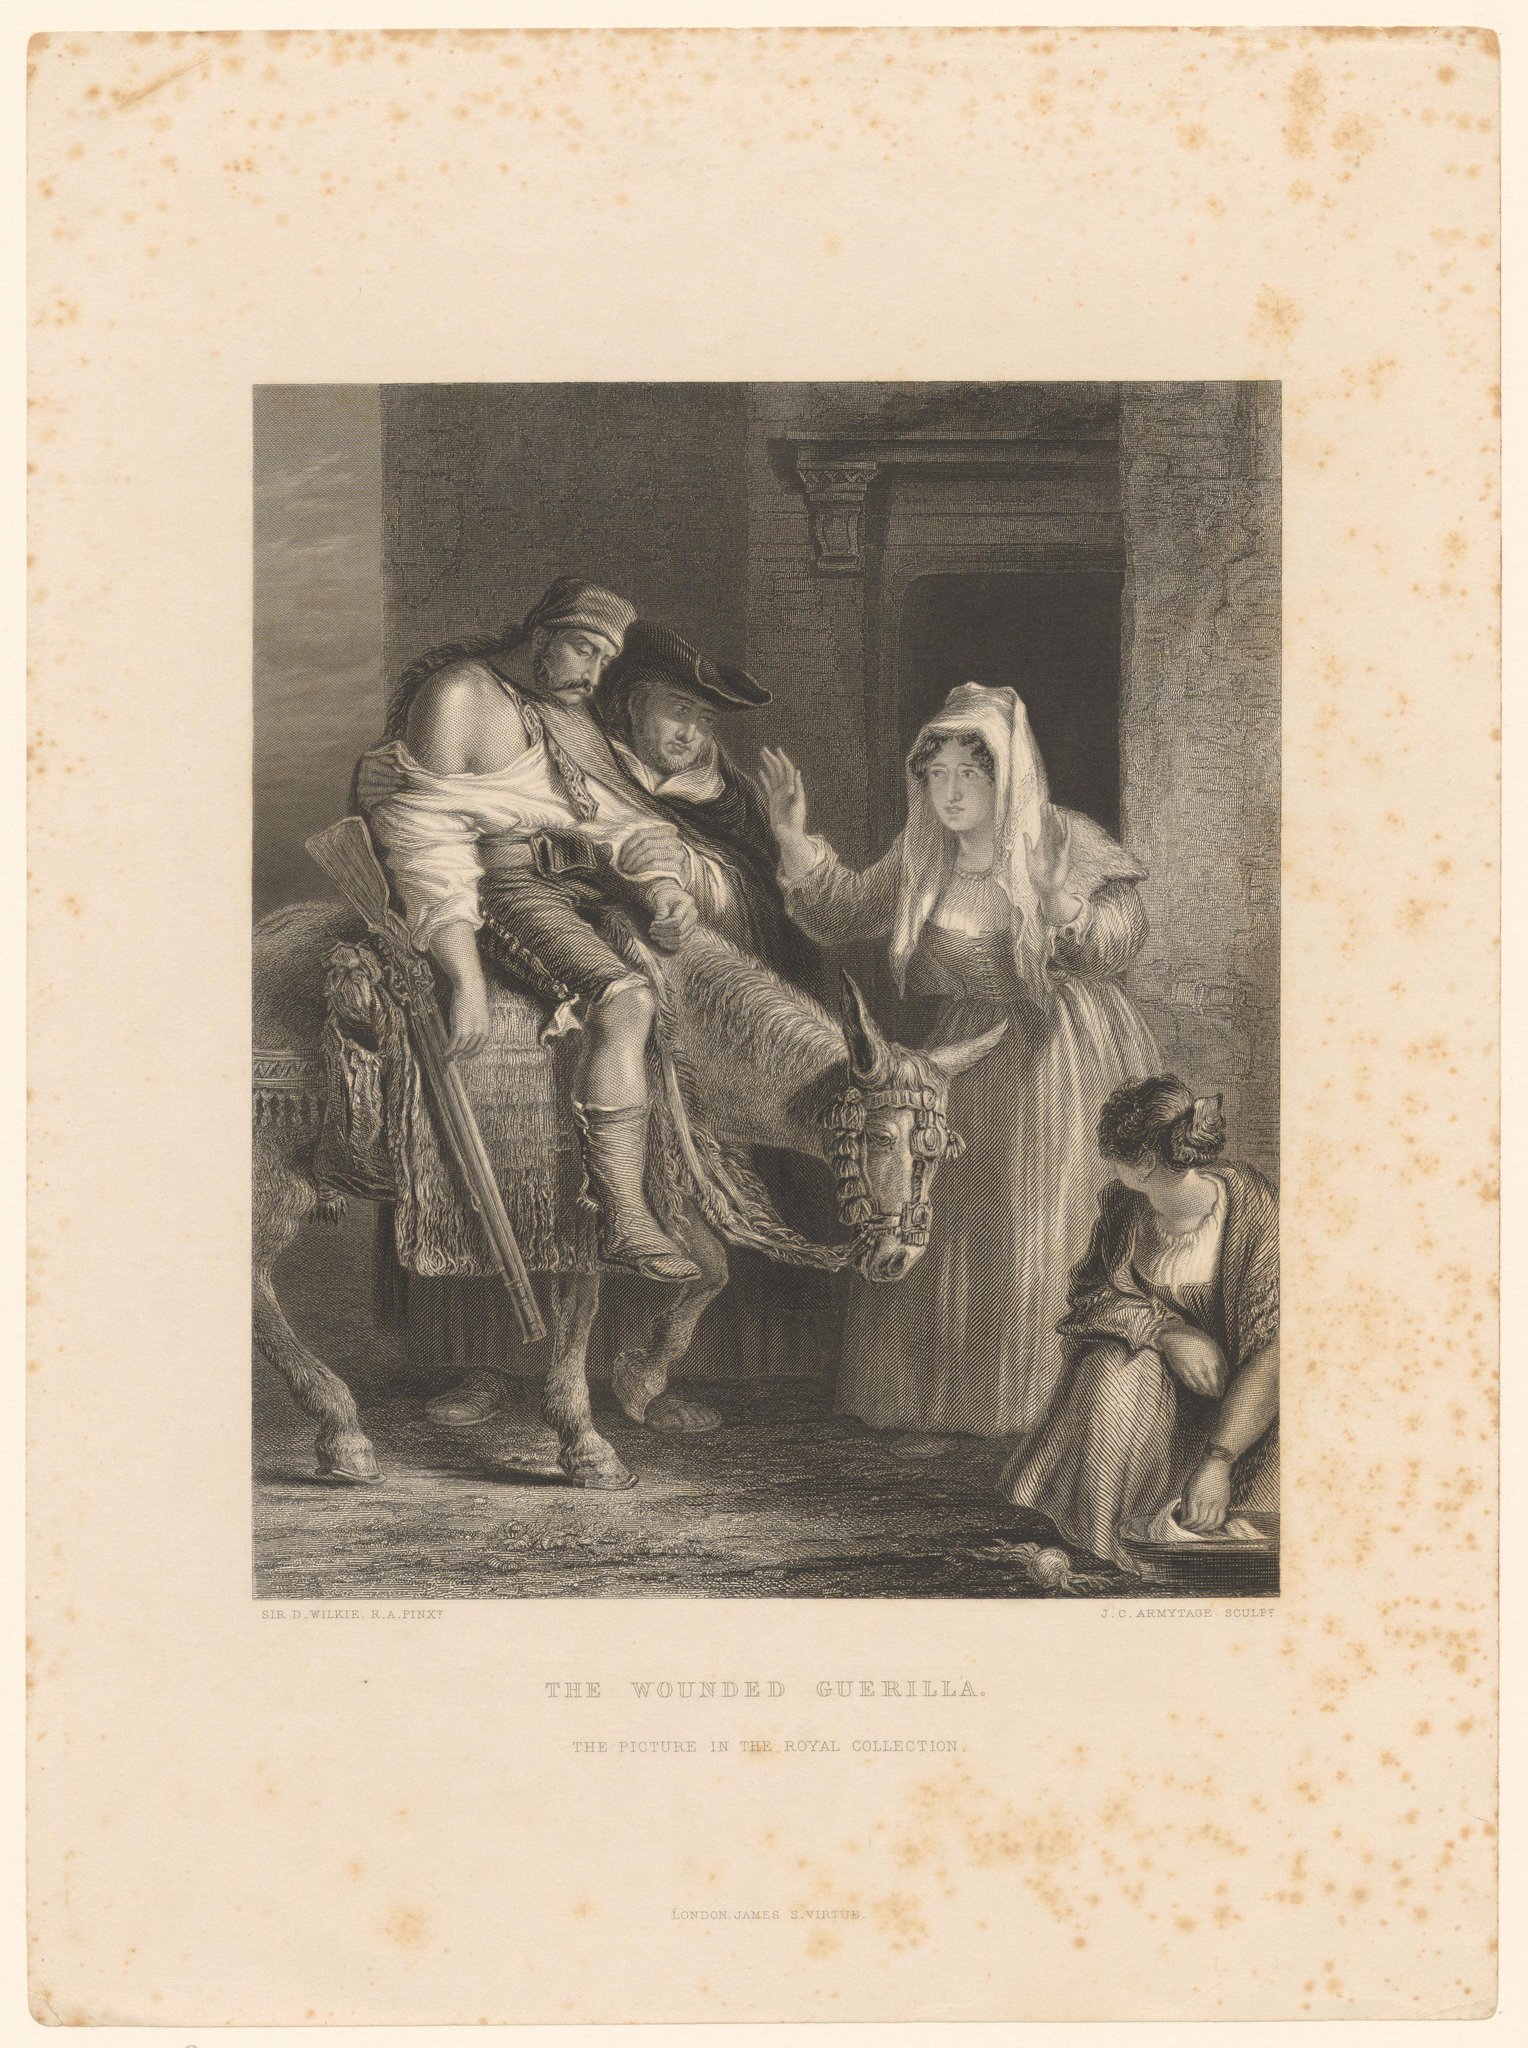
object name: print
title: The Wounded Guerilla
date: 1861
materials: paper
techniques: engraving, etching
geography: london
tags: riding a horse, ass, or mule; rider, horseman, transport of the sick, wounded and dead (military), consequences of war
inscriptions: collector's mark: Lugt 2228